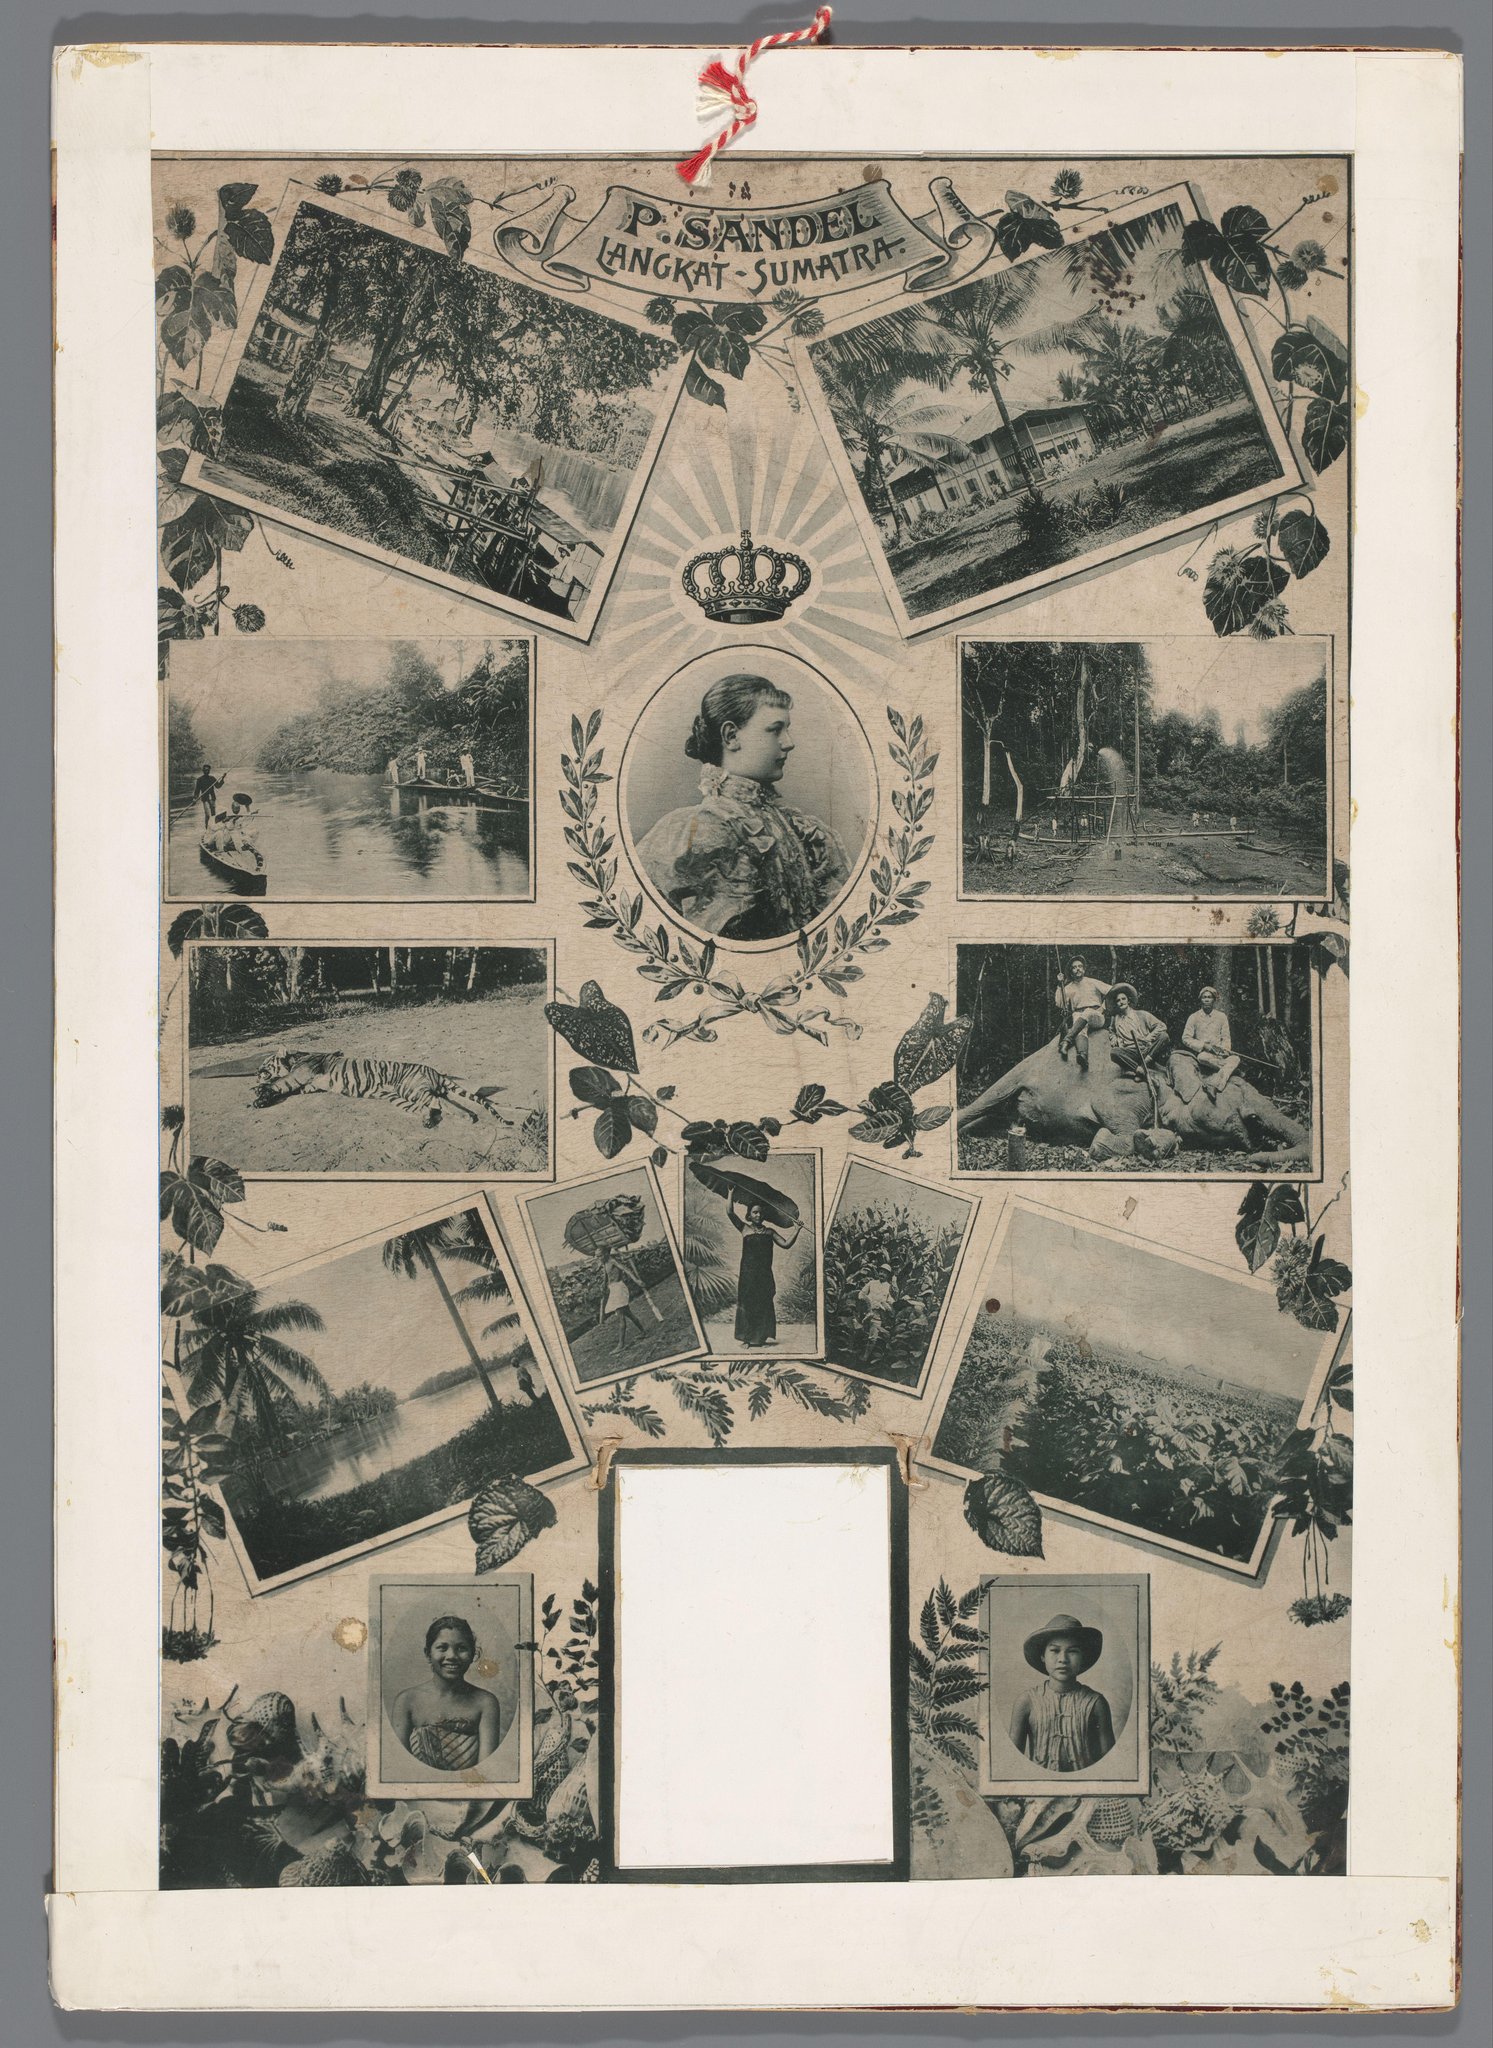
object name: photomechanical print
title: P. Sandel/ Langkat - Sumatra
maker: Anonymous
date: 1890-1920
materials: cardboard, paper, textile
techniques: photograph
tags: print maker, wilhelmina of the netherlands, paul sandel, plantation, historical persons, queen, game, hunted animals, jungle, country-house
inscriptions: inscription: ‘Sumatra O.K./ Handel Mij. Th. Konow Soeberg/ & Co./ (Agenten voor Langkat,/ Tandjoeng Poera)/ Güntzel & Schu-/ macher, Medan’, inscription: ‘O. Sandel (...) 2130’